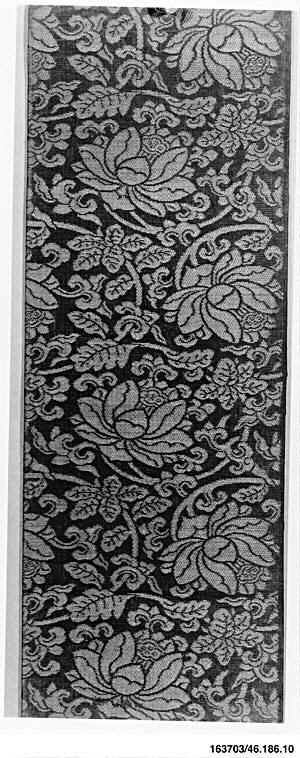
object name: sutra cover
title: Sutra Cover with Lotus Scroll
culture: chinese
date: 1501-1600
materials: silk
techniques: patterning, weave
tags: lotuses,leaves